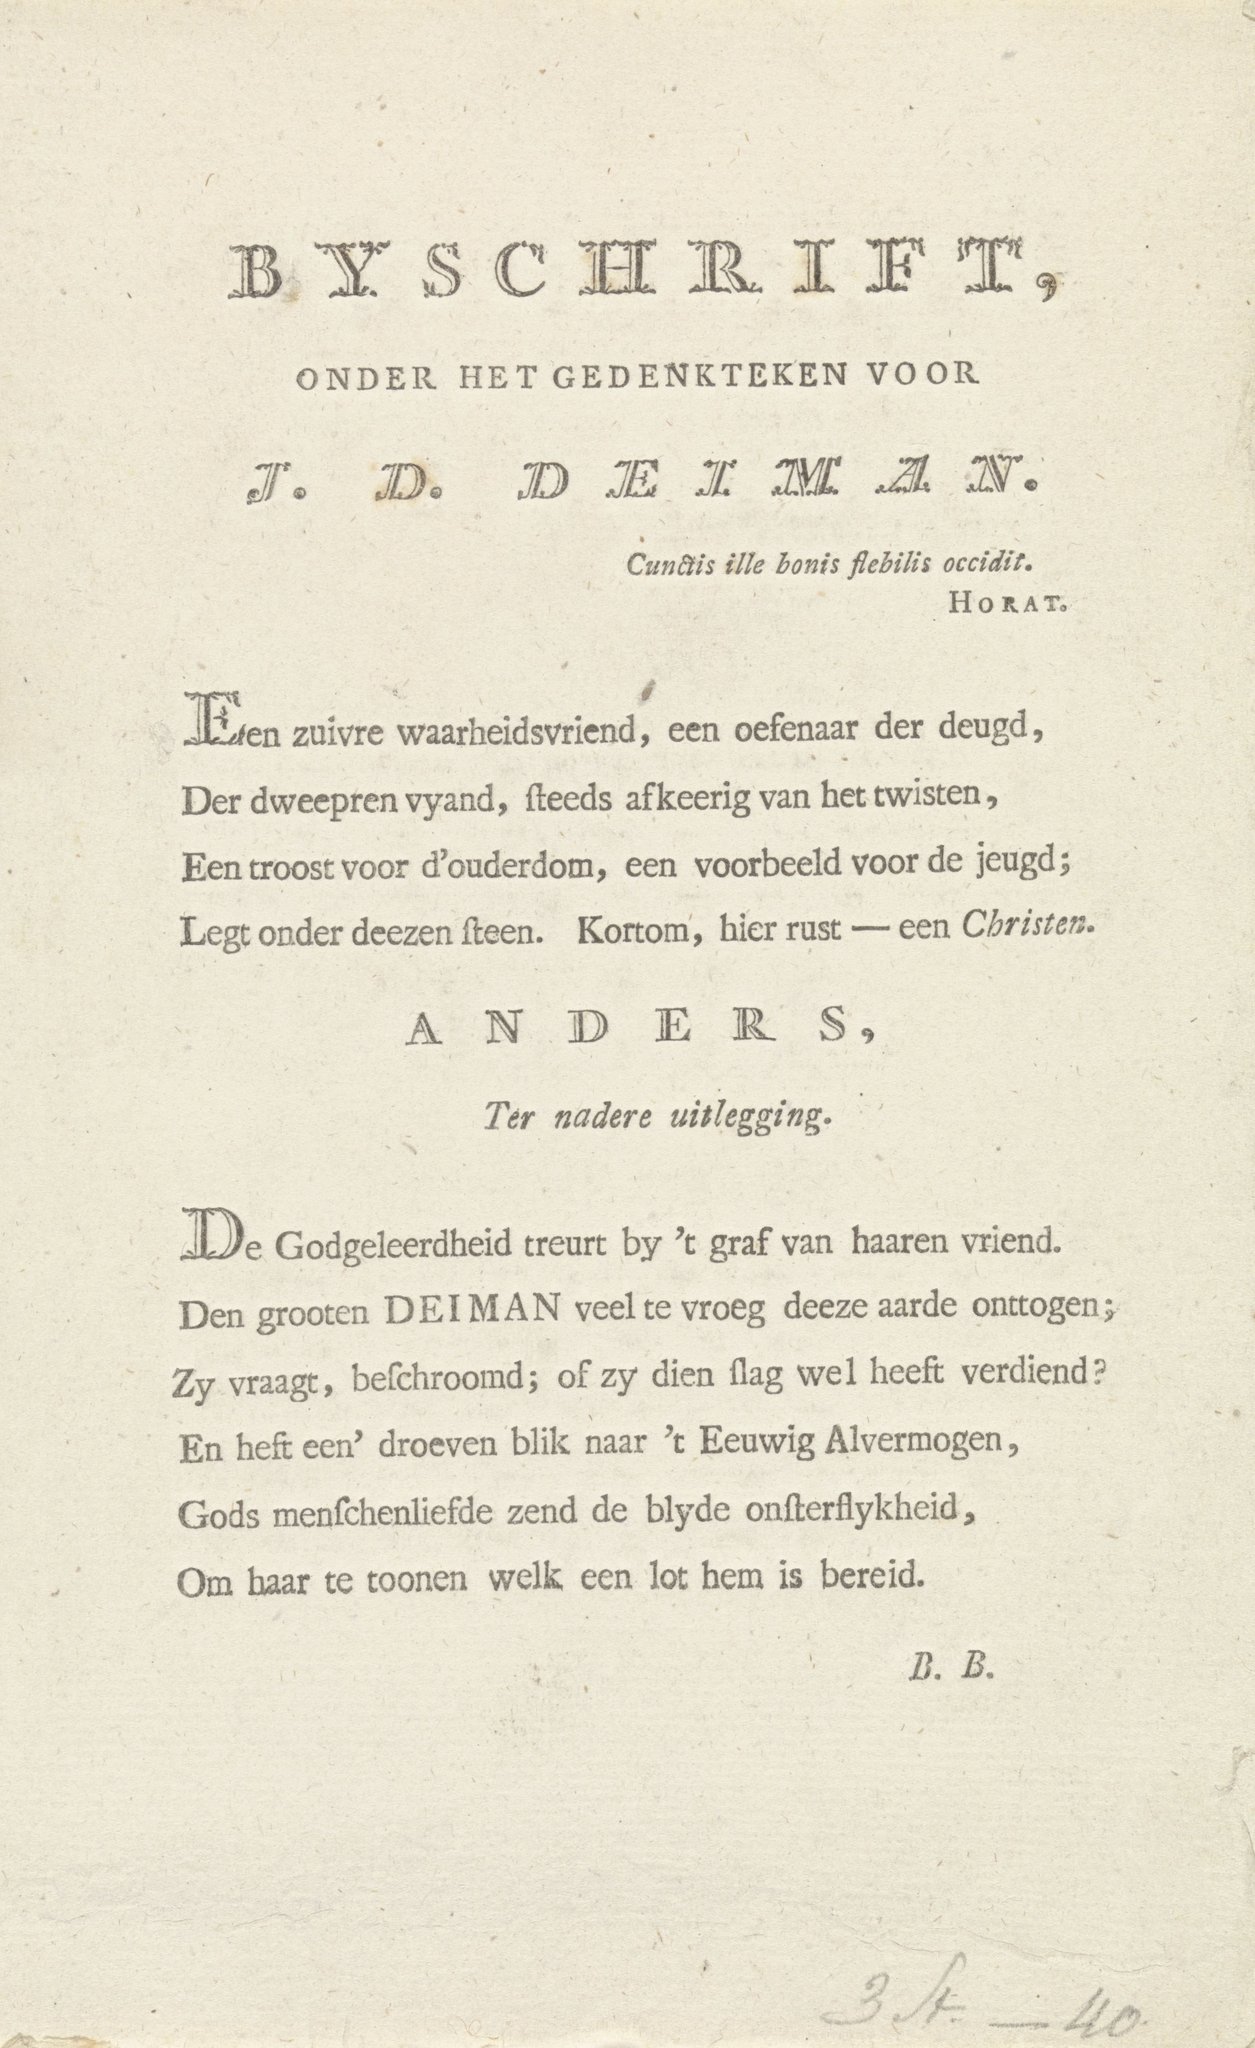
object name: tekst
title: Bijschrift bij het gedenkteken voor Johan Diederich Deiman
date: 1797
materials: paper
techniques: letterpress printing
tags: predikant, johan diederich deiman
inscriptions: collector's mark: Lugt 2228